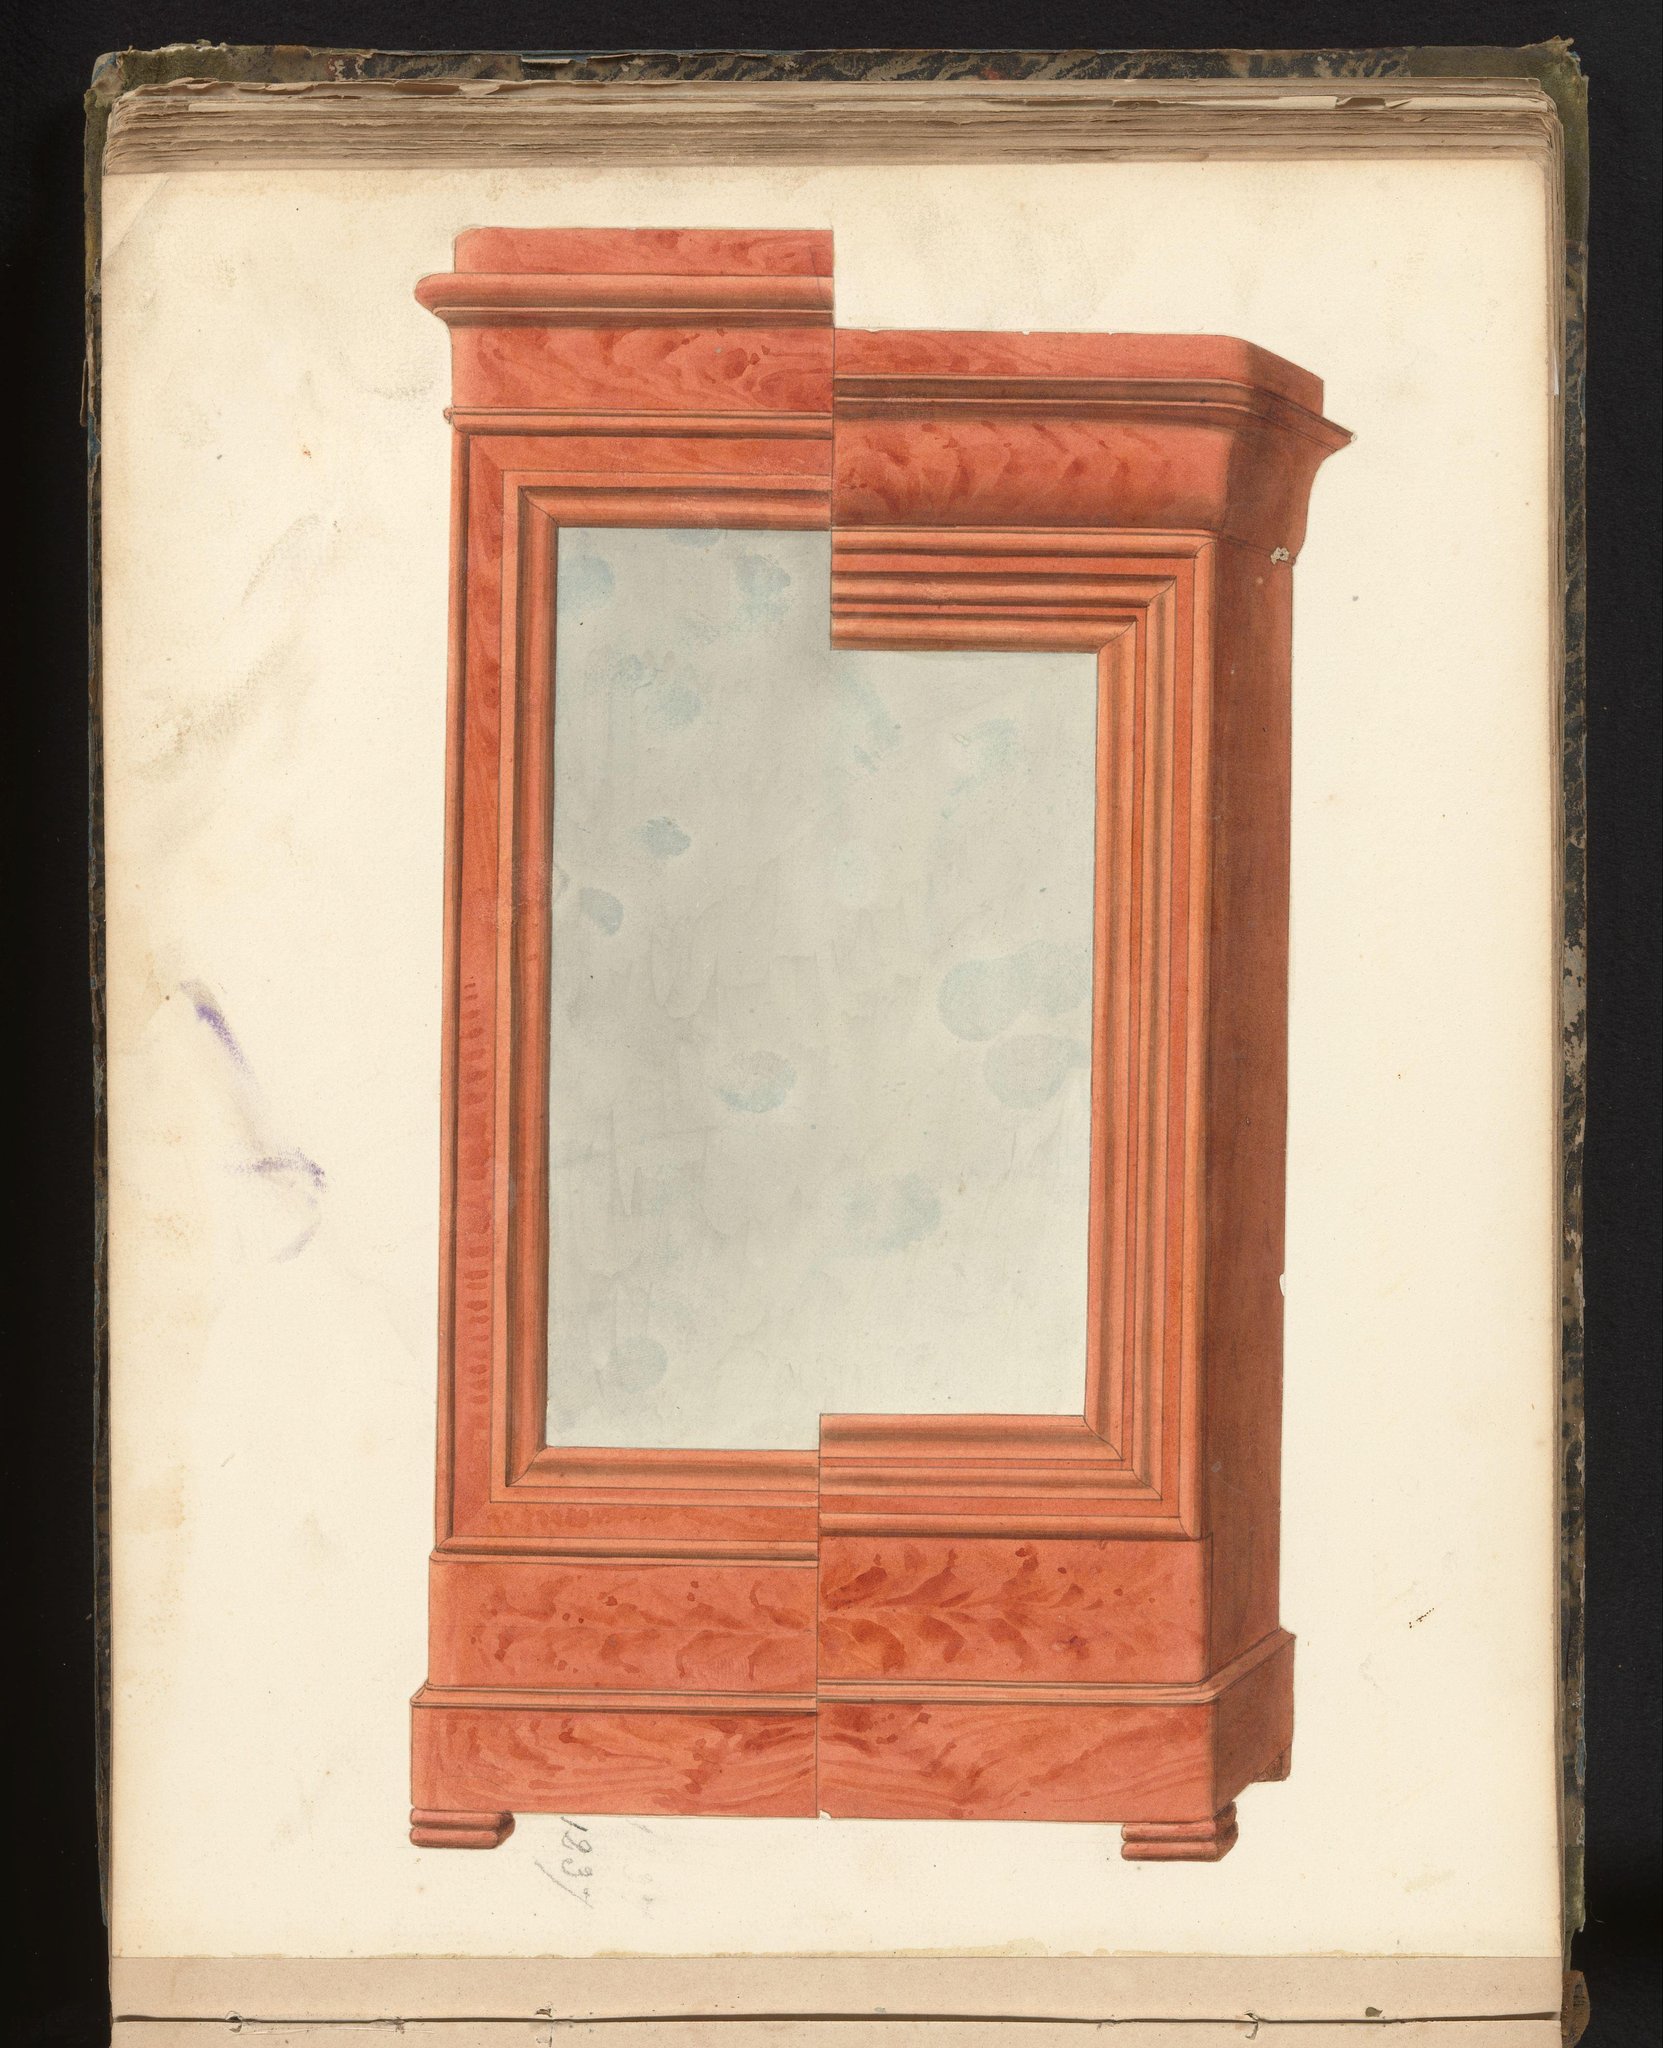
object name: drawing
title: Twee ontwerpen voor kasten met een spiegel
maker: Anonymous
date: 1825-1839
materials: ink, paper, pencil, watercolor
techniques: brush, pen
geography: paris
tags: table (+ wood and other phytogenic material)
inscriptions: inscription: ‘1237 Armoire à glace à boudin cadre flat glace 45 = 25’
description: Twee ontwerpen voor kasten met een spiegel en een lade onderin. Het blad op de achterzijde genummerd: 74, het tegenoverliggende blad met informatie over de afgebeelde meubelen genummerd: 74 bis. Onderdeel van een album met 80 bladen met tekeningen en een prent van gefineerde en gelakte meubelen, alsmede zitmeubelen.